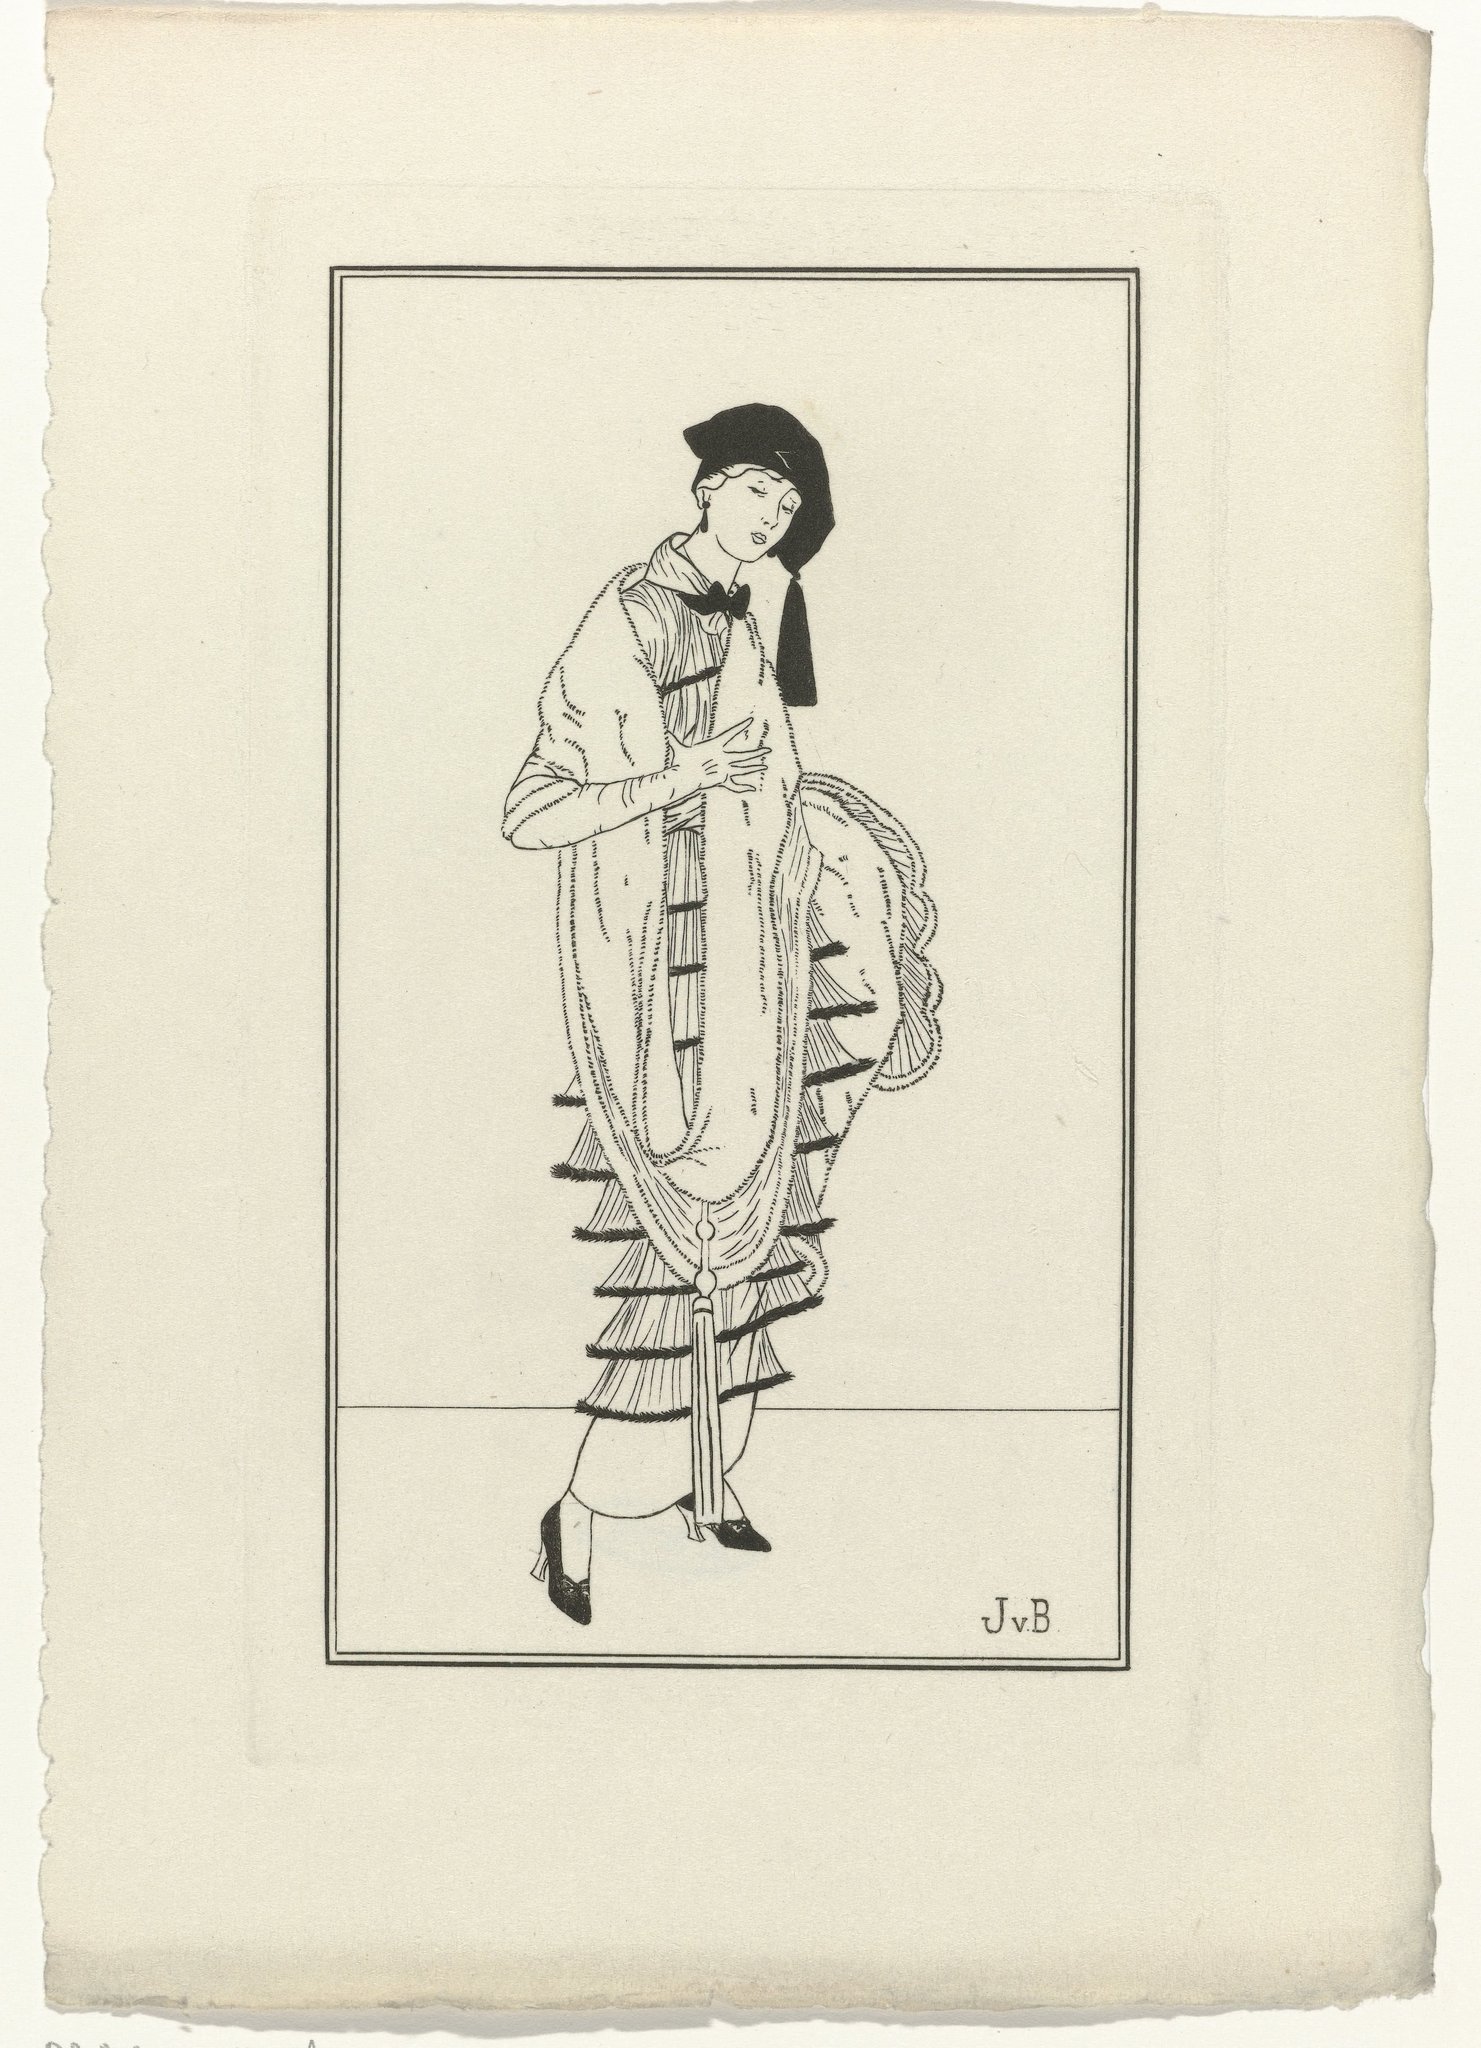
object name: fashion print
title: Journal des Dames et des Modes, Costumes Parisiens, 1914, No. 132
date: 1914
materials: paper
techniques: engraving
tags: head-gear (+ women's clothes), fashion plates, dress, gown (+ women's clothes), clothing for the upper part of the body (shawl) (+ fur used for clothes)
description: Japon met geplooide stroken stof. 'Parure' van hermelijn. Pumps met rode hakken. Proefdruk voor prent in het modetijdschrift Journal des Dames et des Modes (1912-1914). In de versie met tekst: Robe à volants - Parure d'hermine.